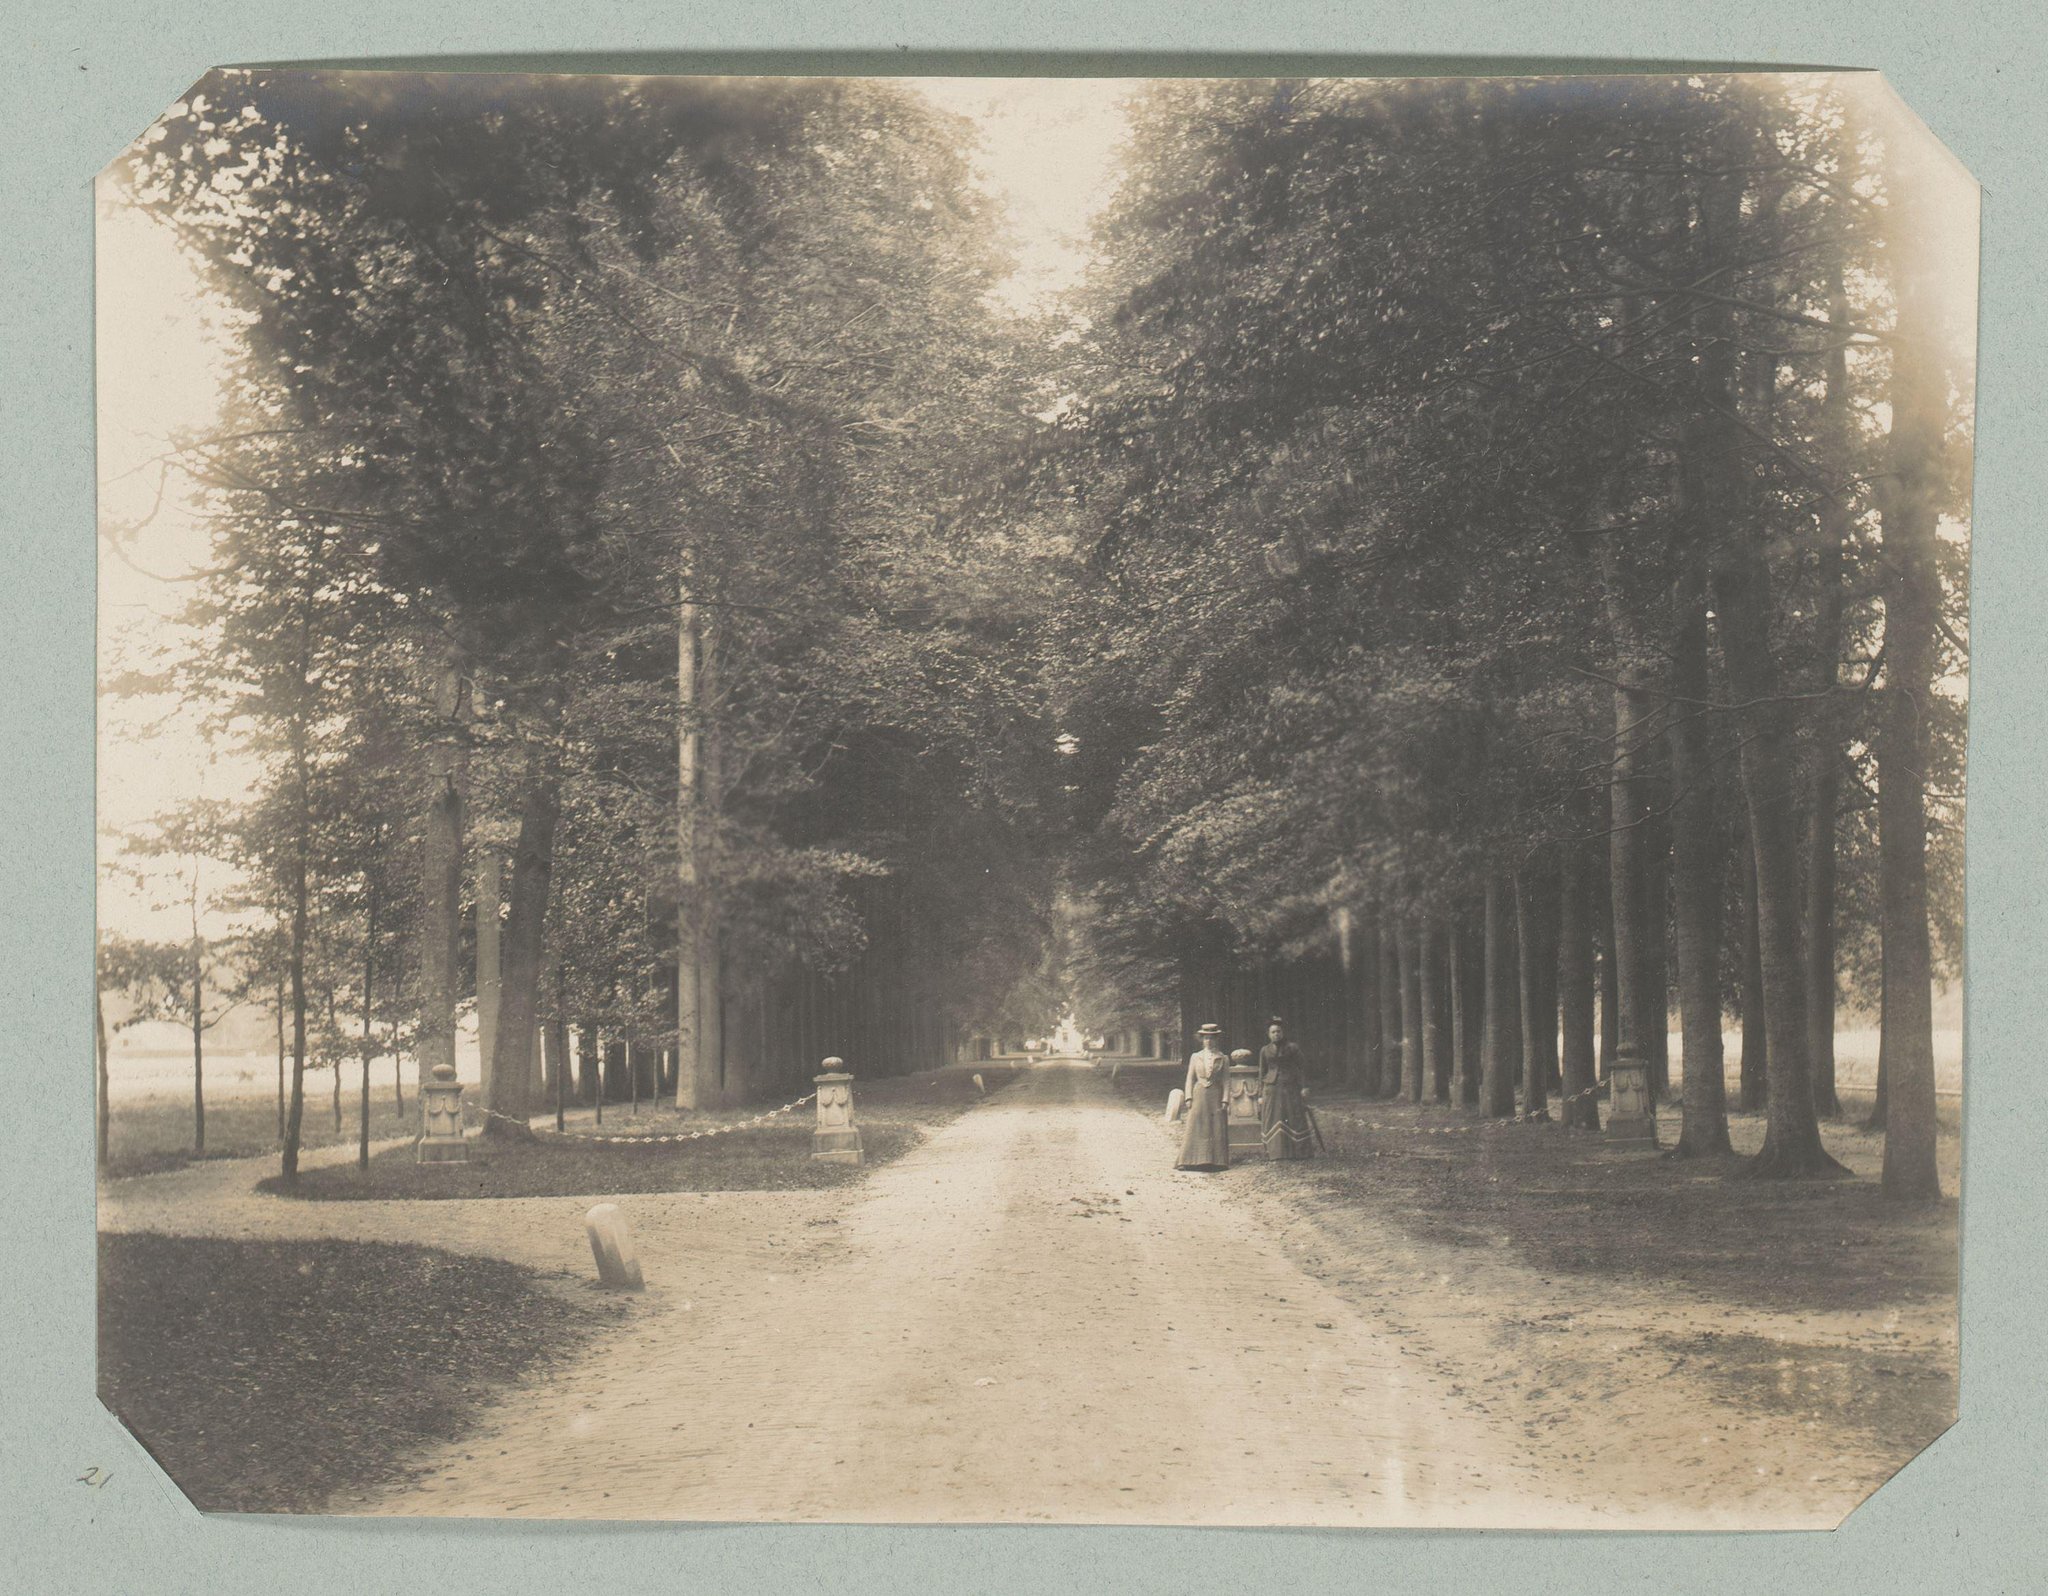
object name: photograph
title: Twee vrouwen op een laan met bomen in Nederland, mogelijk bij Amelisweerd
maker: Anonymous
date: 1890-1900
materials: paper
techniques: gelatin silver print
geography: netherlands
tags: forest path or lane, netherlands